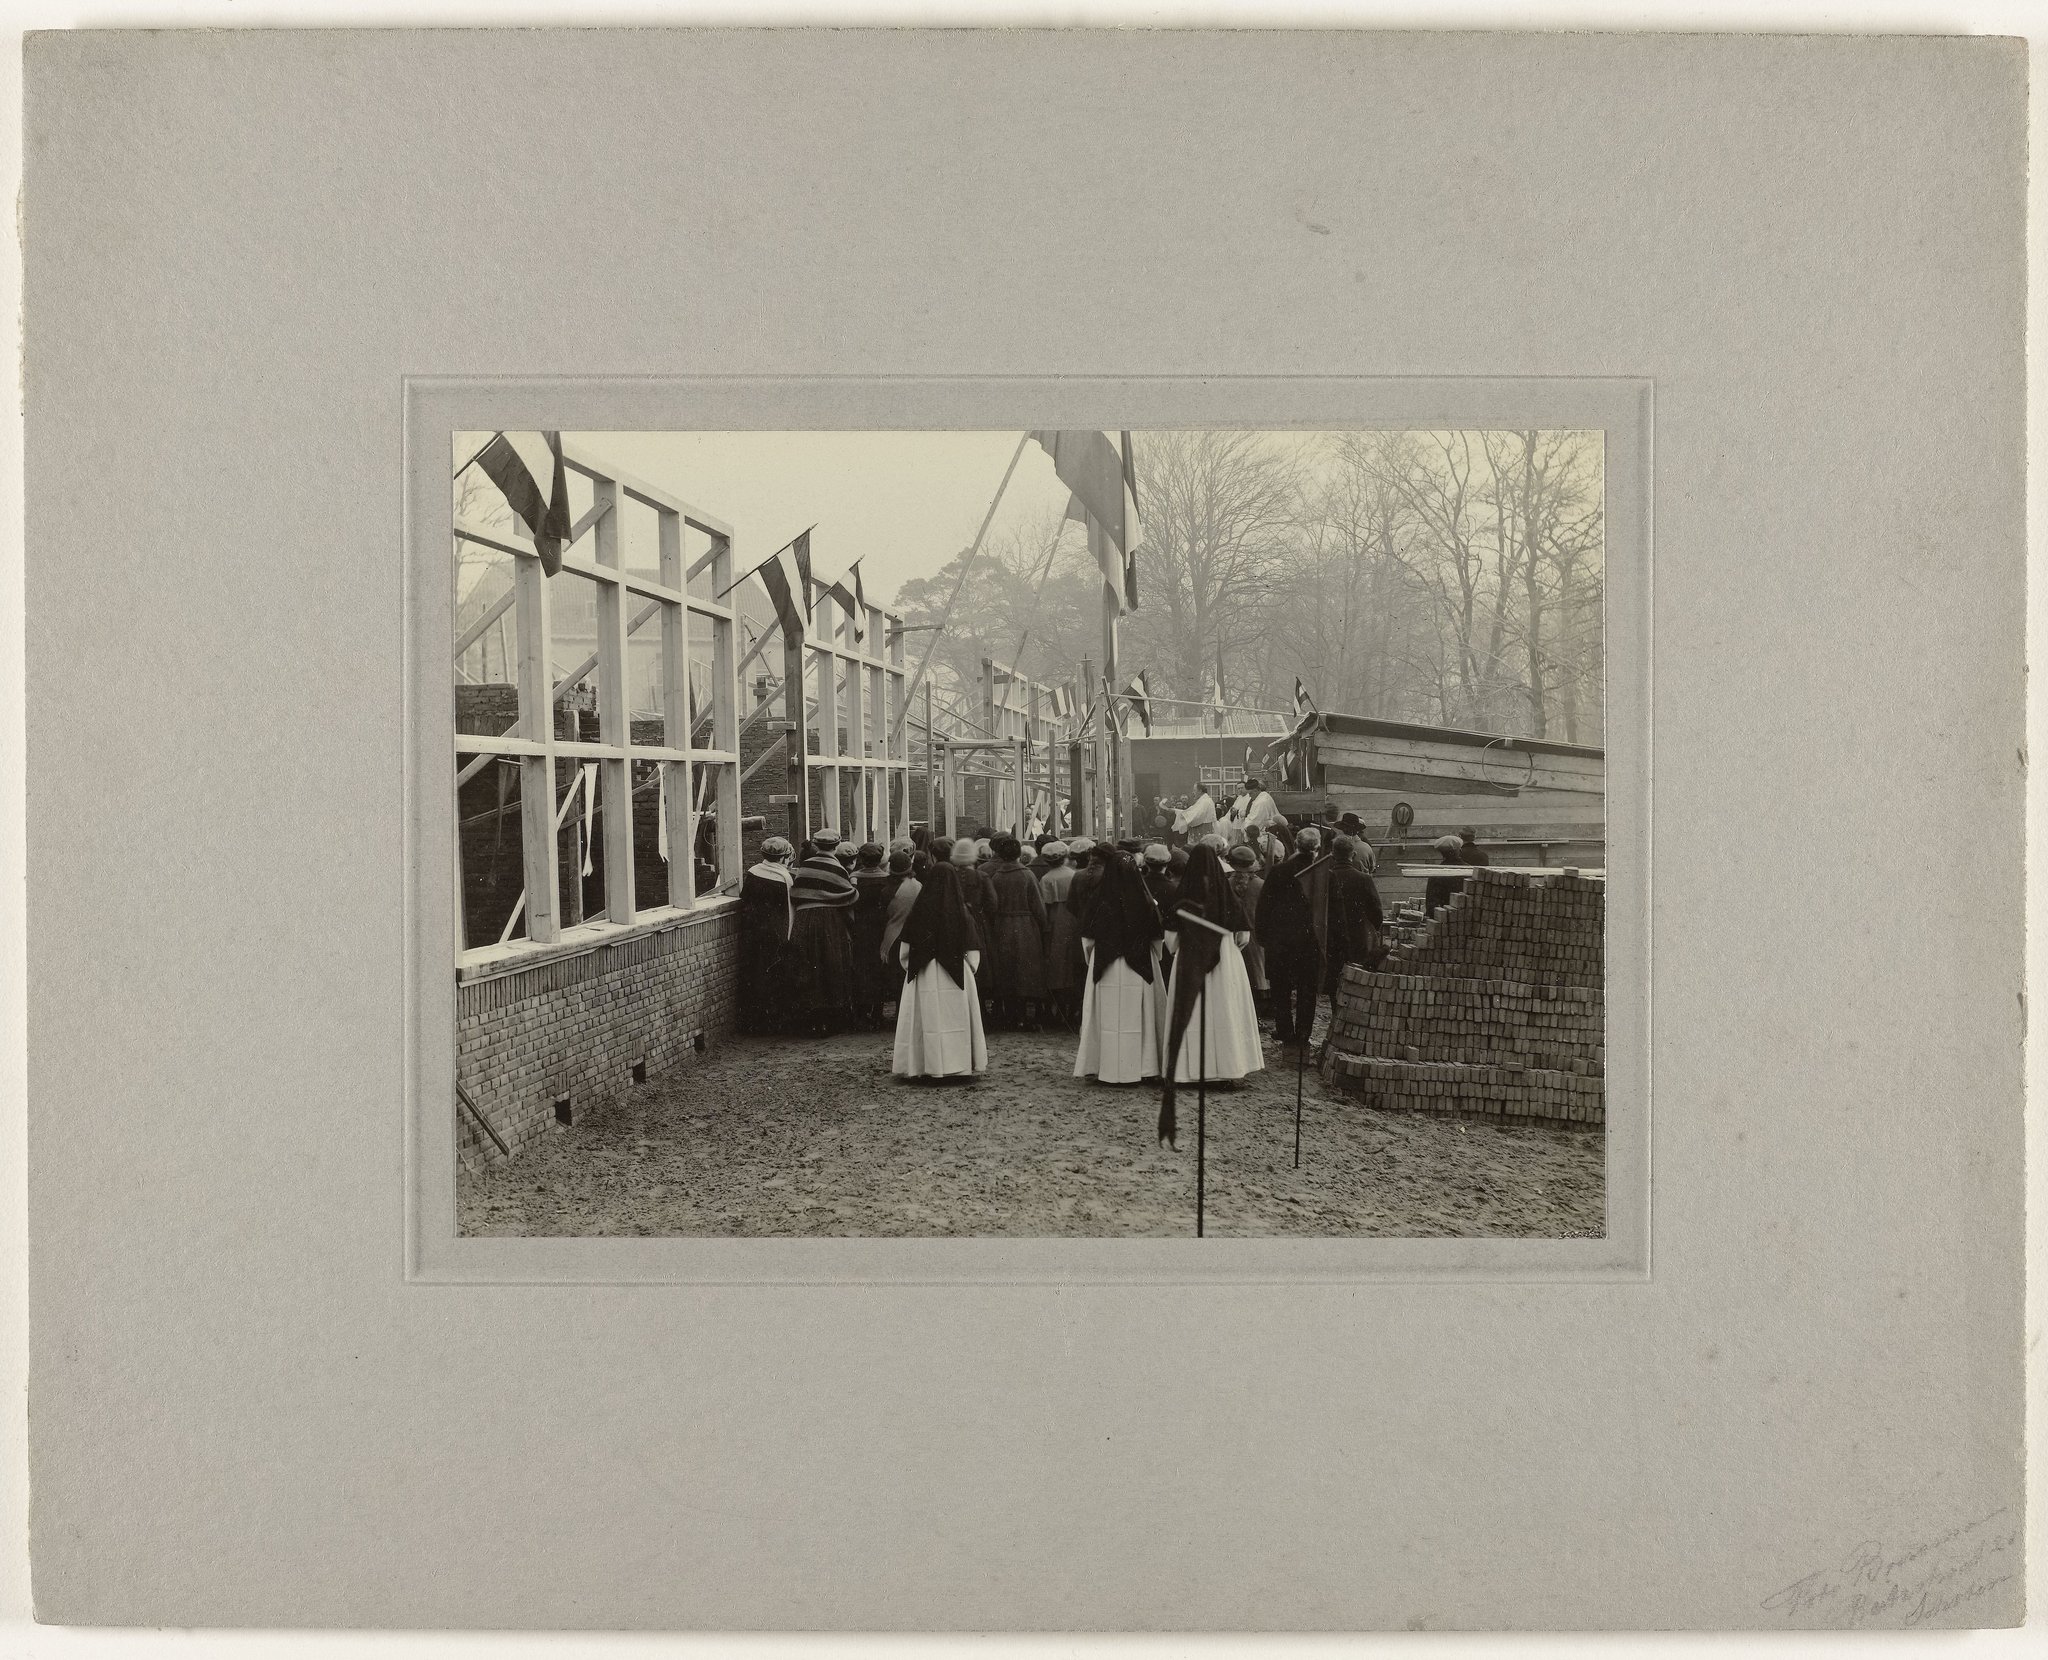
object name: photograph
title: Inzegening lagere school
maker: Anonymous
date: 1920-1930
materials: photographic support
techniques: photography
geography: netherlands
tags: netherlands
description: Bij een school in aanbouw zijn katholieke geestelijken bezig de school te zegenen. Op de voorgrond een paar nonnen, daarachter kinderen. Aan de kozijnen hangen Nederlandse vlaggen.